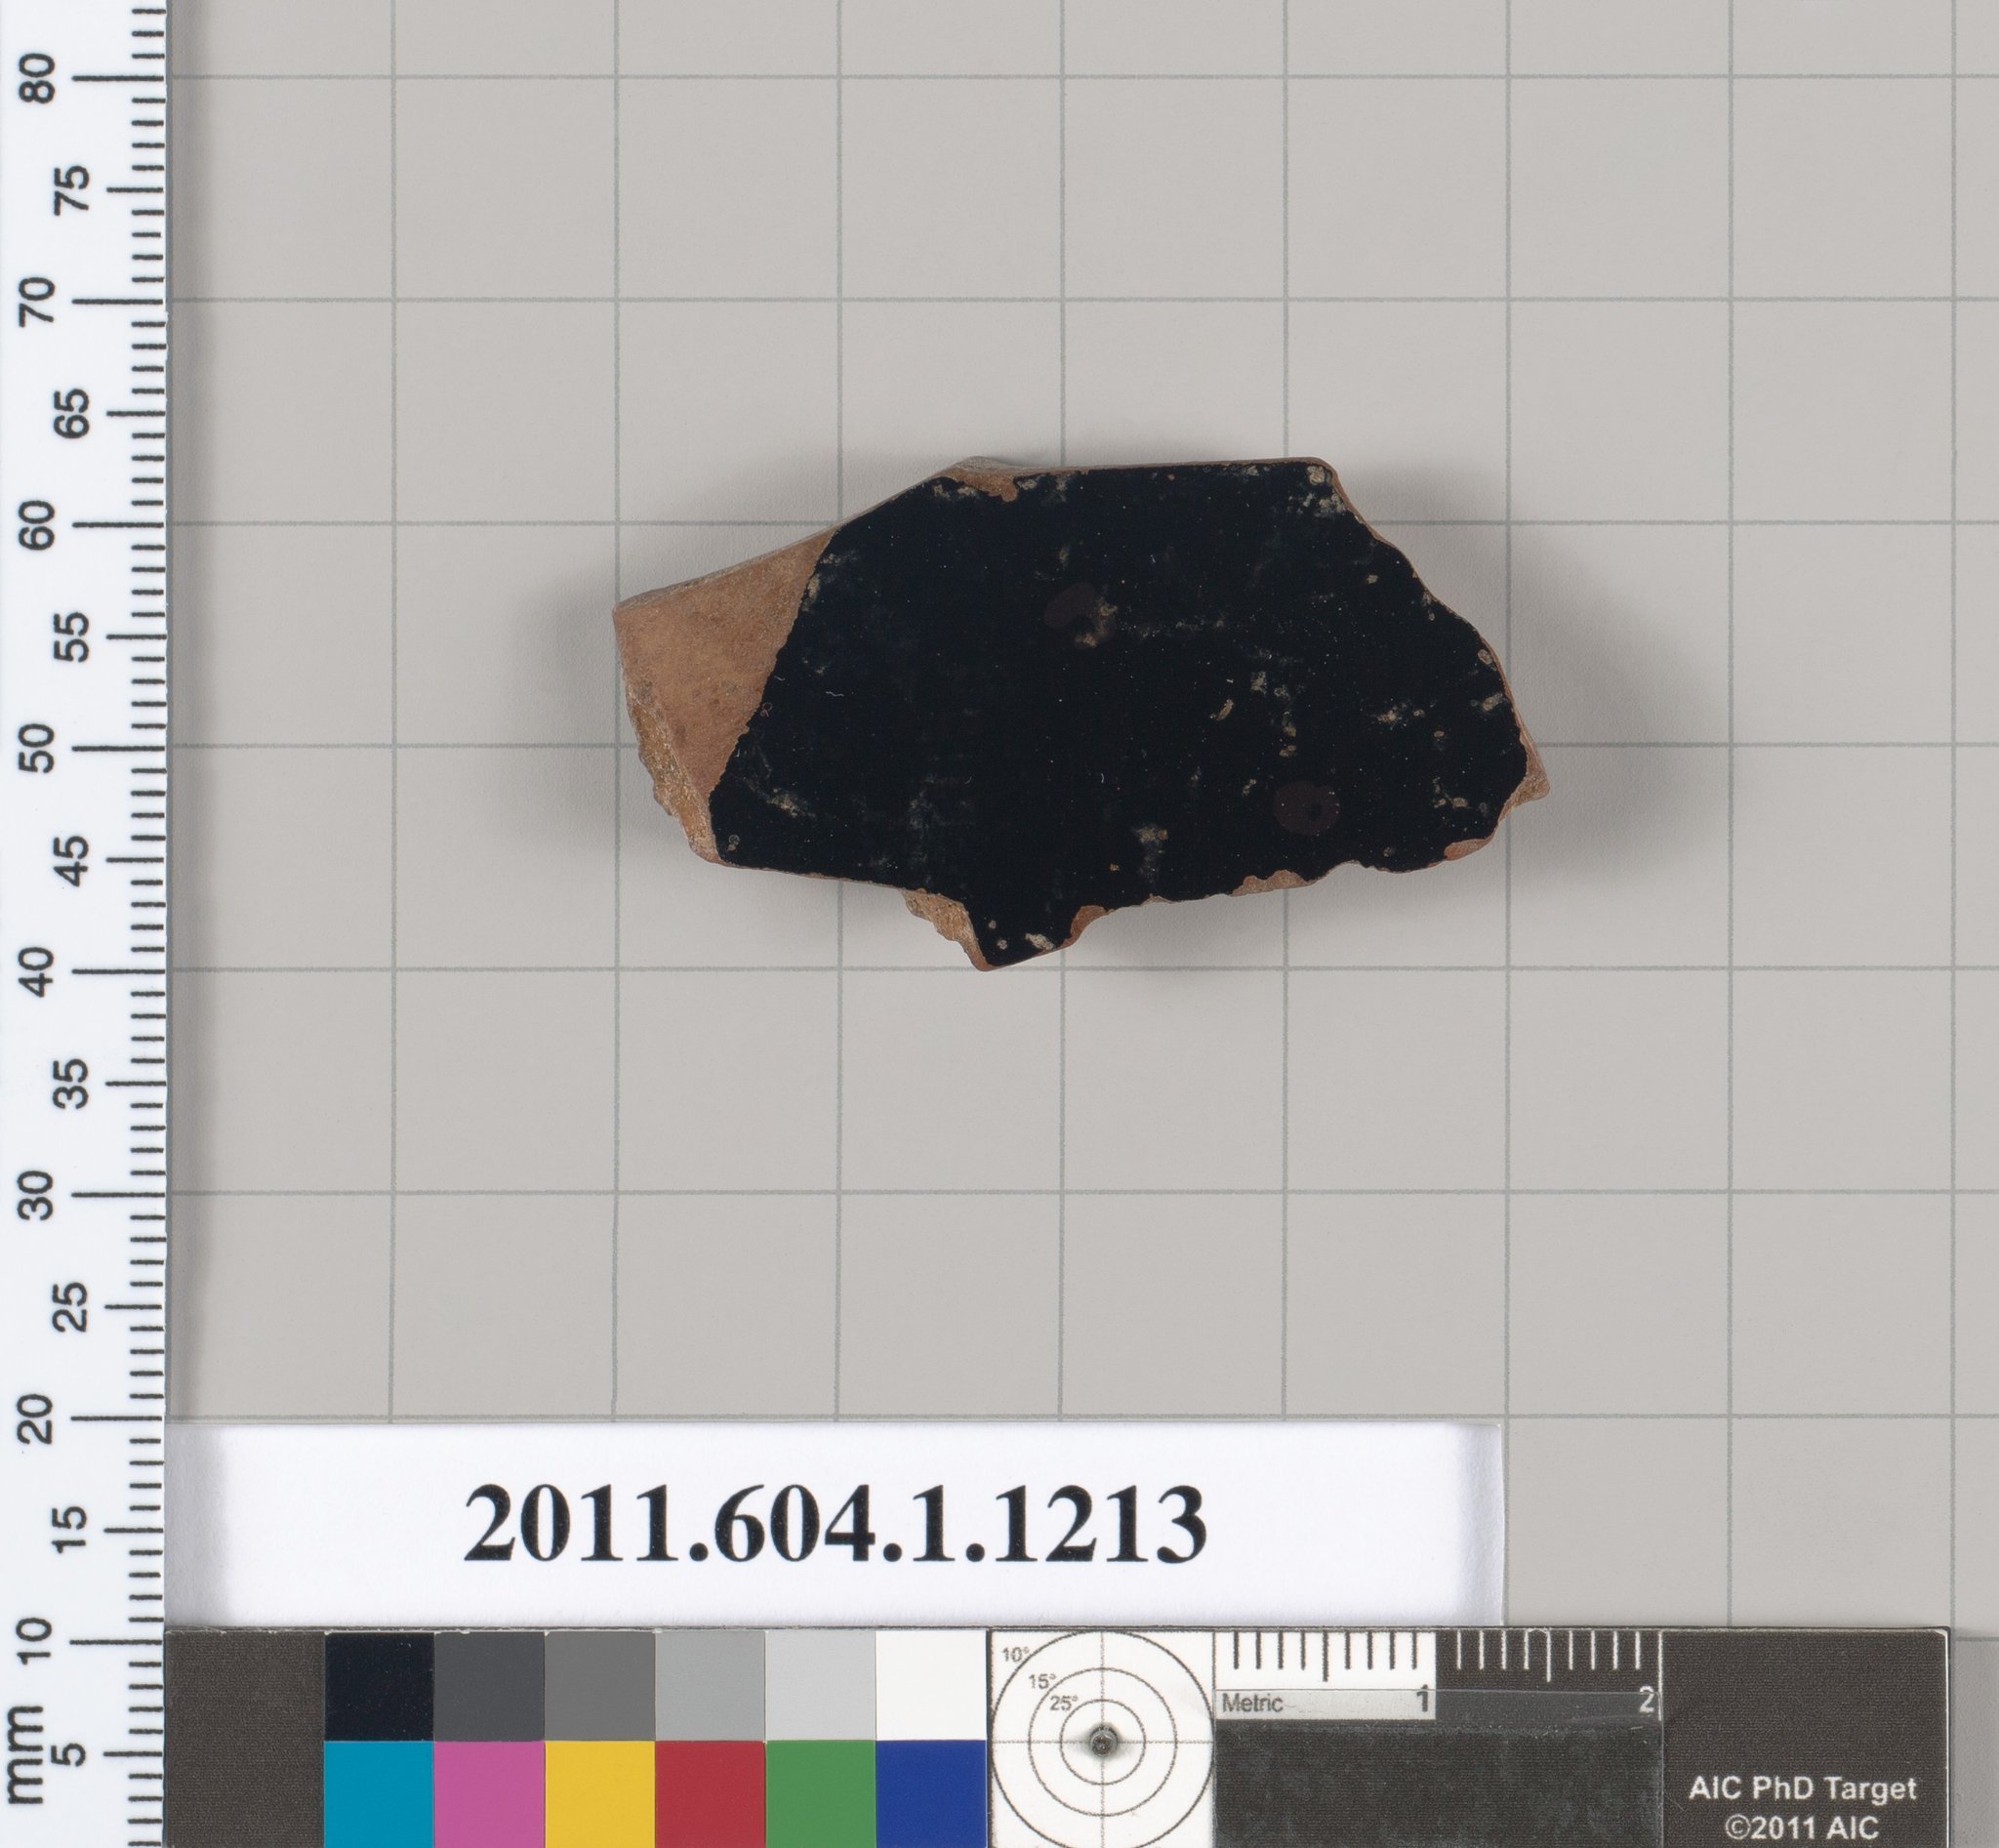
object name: kylix fragment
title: Terracotta fragment of a kylix (drinking cup)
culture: greek, attic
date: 490-480 BCE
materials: terracotta